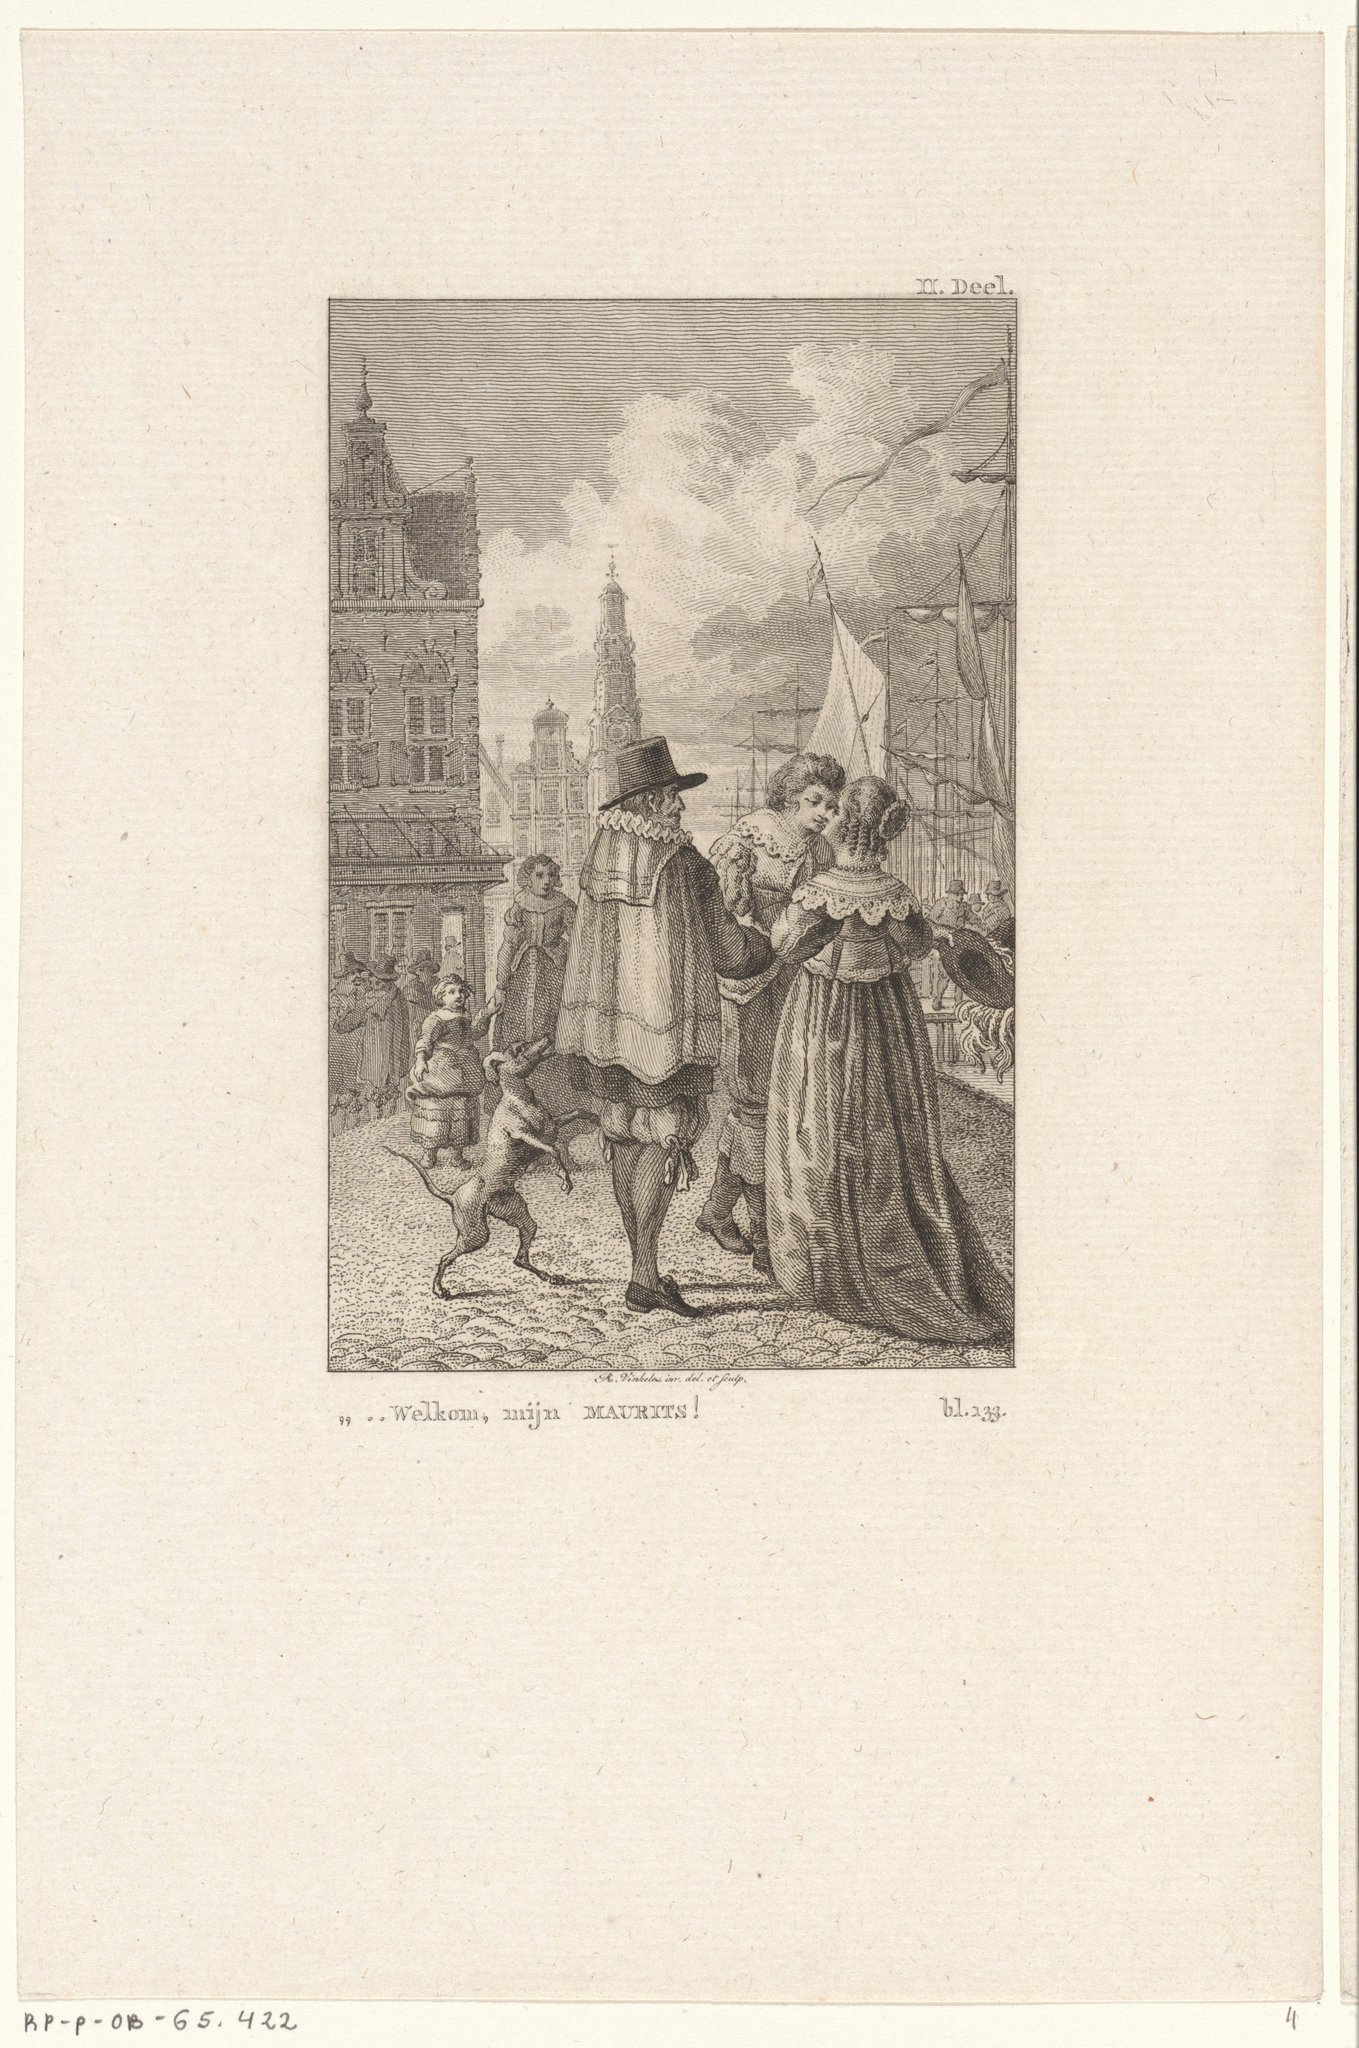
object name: print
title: Op een kade wordt Maurits welkom geheten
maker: reinier vinkeles (i)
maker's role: draughtsman, print maker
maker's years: 1741-1816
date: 1808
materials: paper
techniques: engraving, etching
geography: amsterdam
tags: sailing-ship, sailing-boat, being welcomed ~ travelling, quay, dog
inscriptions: collector's mark: Lugt 2228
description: Deze prent is ook gebruikt als illustratie voor: Loosjes, Adriaan Pietersz. Het leven van Maurits Lijnslager : eene Hollandsche familiegeschiedenis uit de zeventiende eeuw. Haarlem: Adriaan Pietersz. Loosjes, 1808, p. 133.